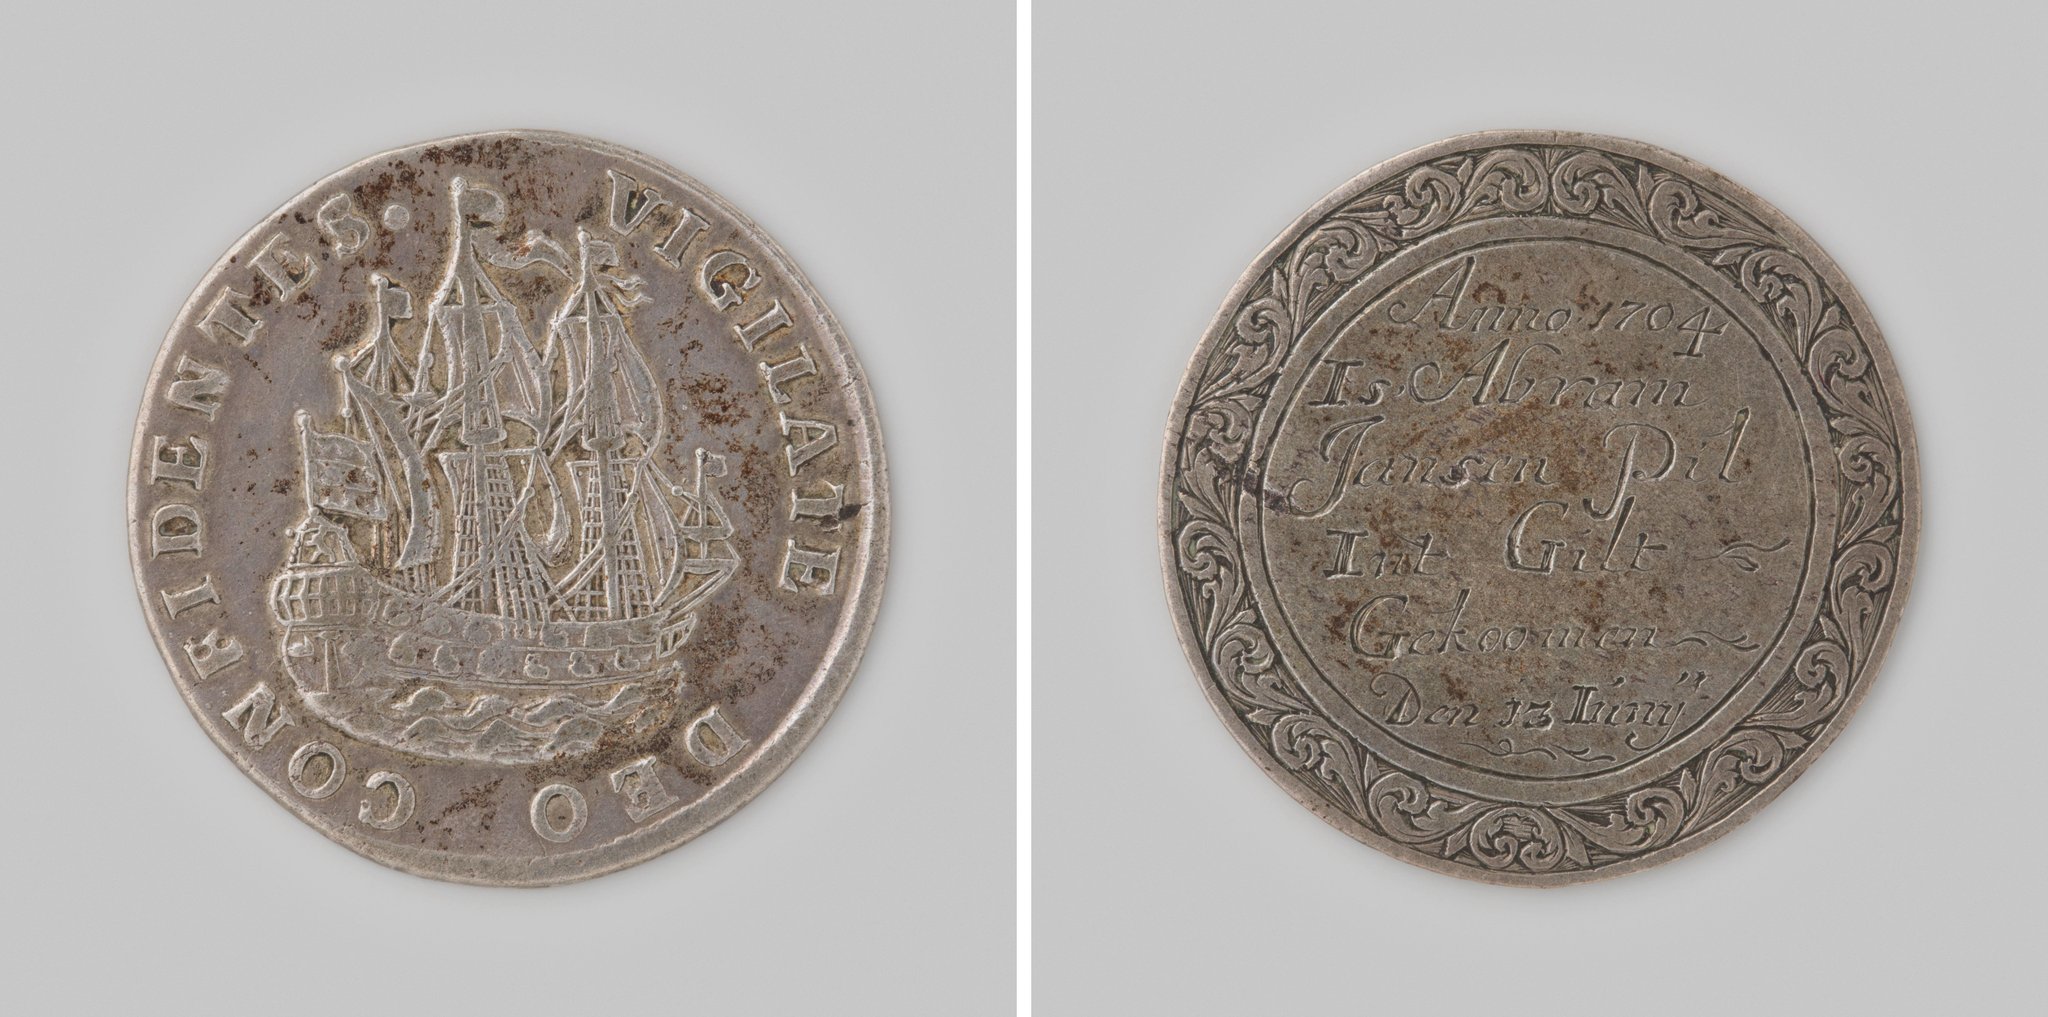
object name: history medal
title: Scheepjesschelling bewerkt tot penning op het toetreden van Abram Jansen Pil tot een gilde 1704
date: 1704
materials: silver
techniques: engraving, grinding, striking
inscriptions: circumscription: ‘VIGILATE DEO CONFIDENTES.’, inscription: ‘Anno 1704 / Is Abram / Jansen Pil / Int Gilt / Gekoomen / den 13 Iunij’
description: Scheepjesschelling, aan de wapenzijde afgeslepen en gegraveerd met zes regels tekst binnen een ornamentale rand.